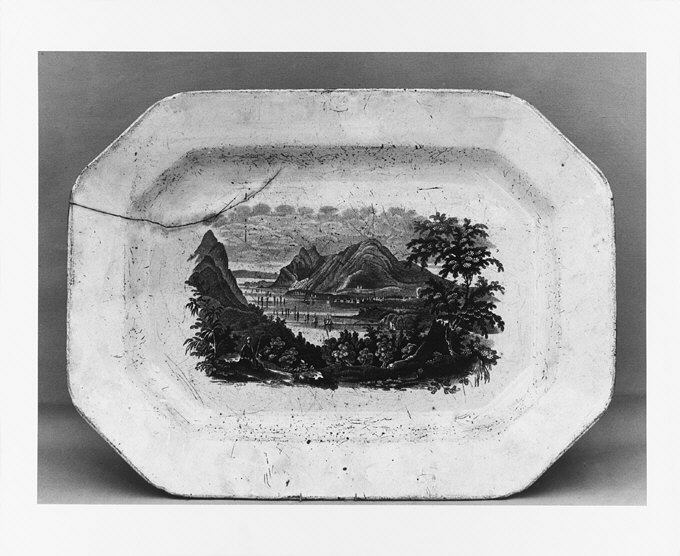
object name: platter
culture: british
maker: william ridgway & co.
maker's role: maker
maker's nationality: british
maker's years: 1834-1854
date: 1840-1854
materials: earthenware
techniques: transfer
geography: england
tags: mountains,landscapes